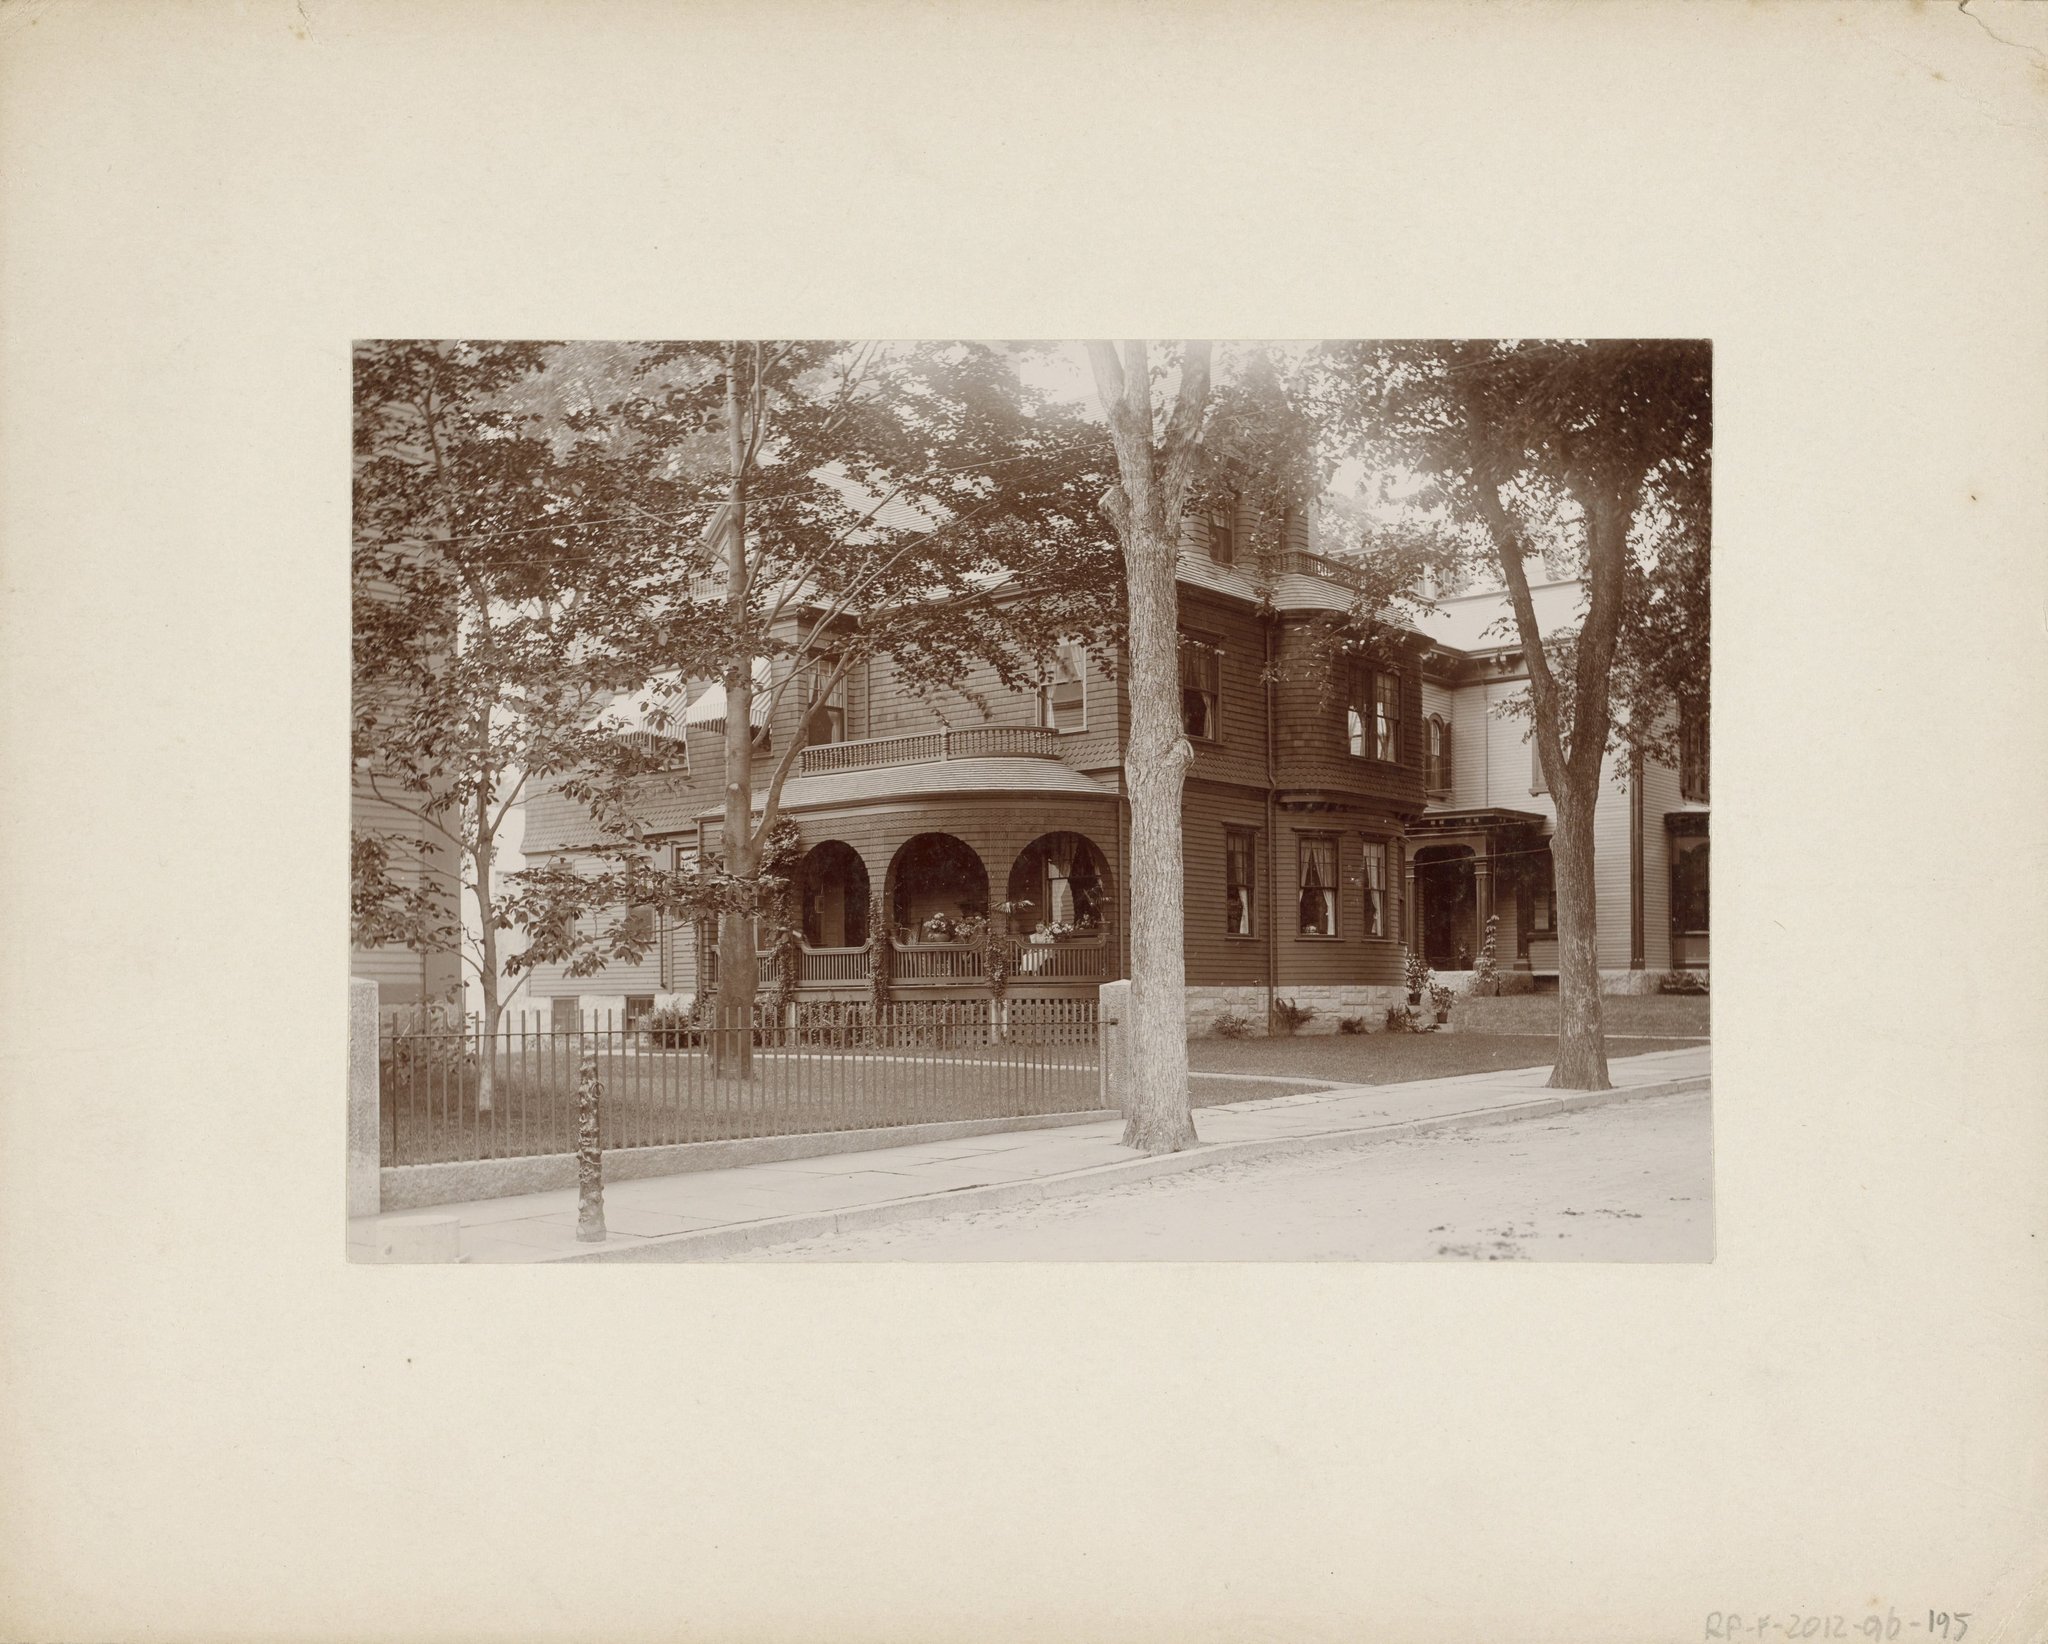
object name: photograph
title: Oostzijde van het huis van Benjamin Anthony in Bedford (Massachusetts)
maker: Anonymous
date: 1893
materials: cardboard, paper, photographic support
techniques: collodion silver print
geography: bedford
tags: rural housing, e.g. country-house, villa, cottage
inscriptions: inscription: ‘House of Benjamin Anthony New bedford, Mass. east front, June 27, 1893’